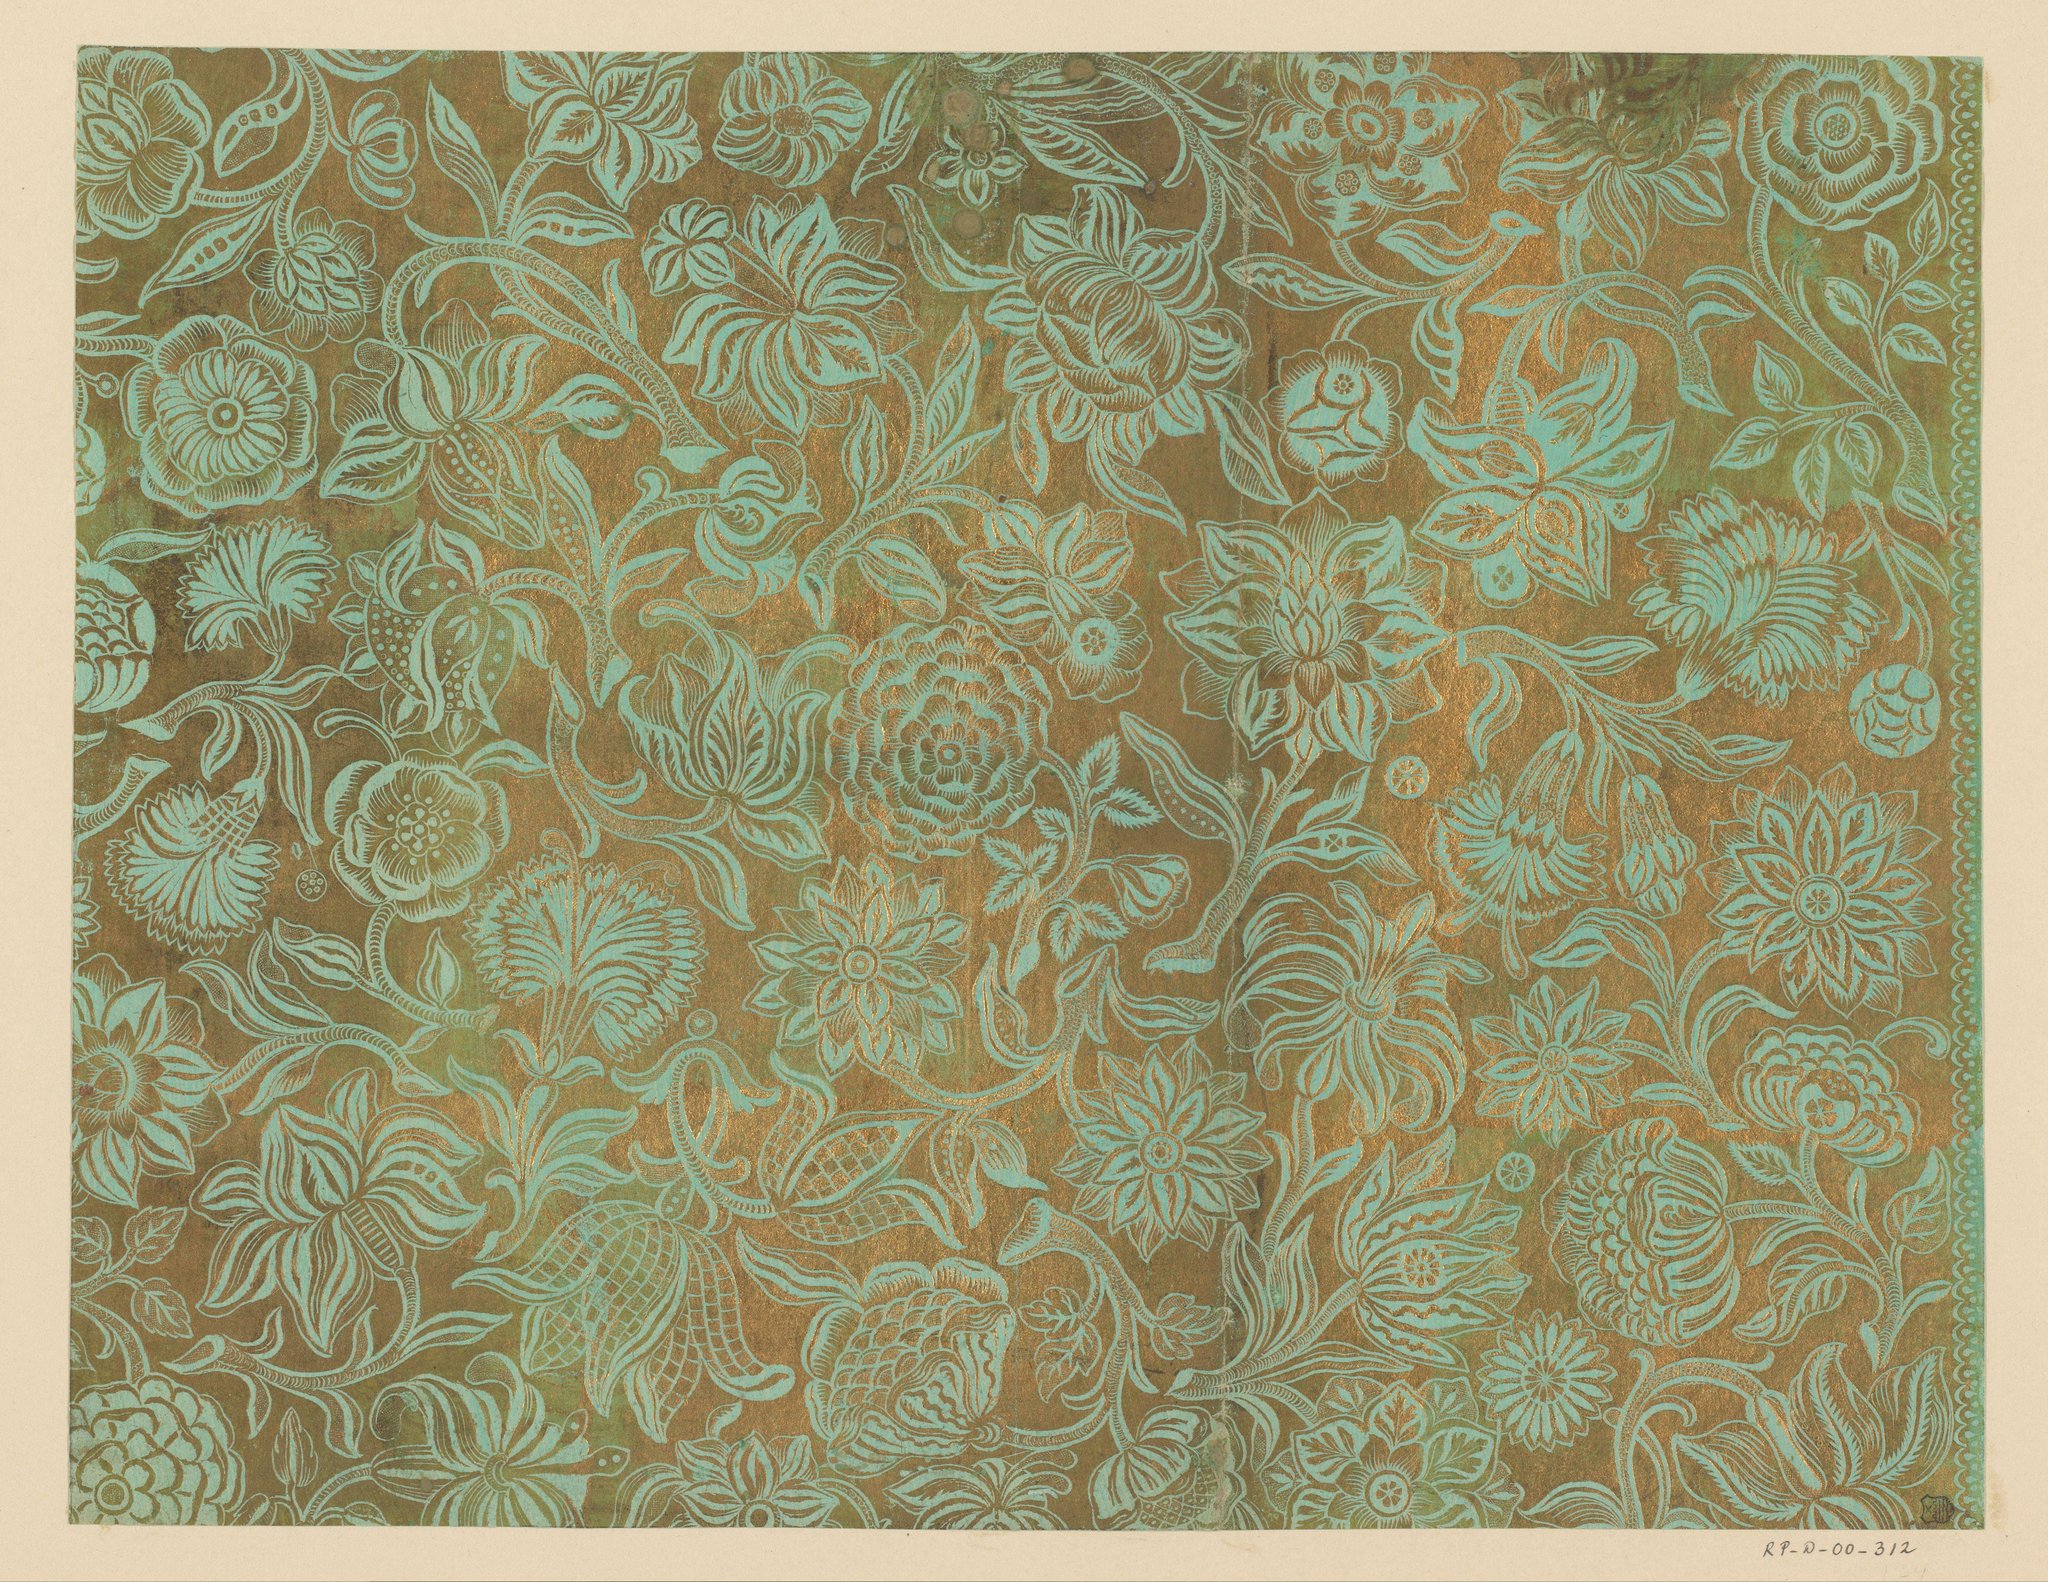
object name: brocade paper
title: Blad met bloemen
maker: johann michael munck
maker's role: ontwerper sierpapier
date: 1730-1760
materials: gold leaf, paint, paper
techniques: relief print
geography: augsburg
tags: ornament derived from plant forms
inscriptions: collector's mark: Lugt 2760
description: Blad met bloemen met aan de rechterzijde een sierlijst bestaande uit halve maantjes en twee punten.